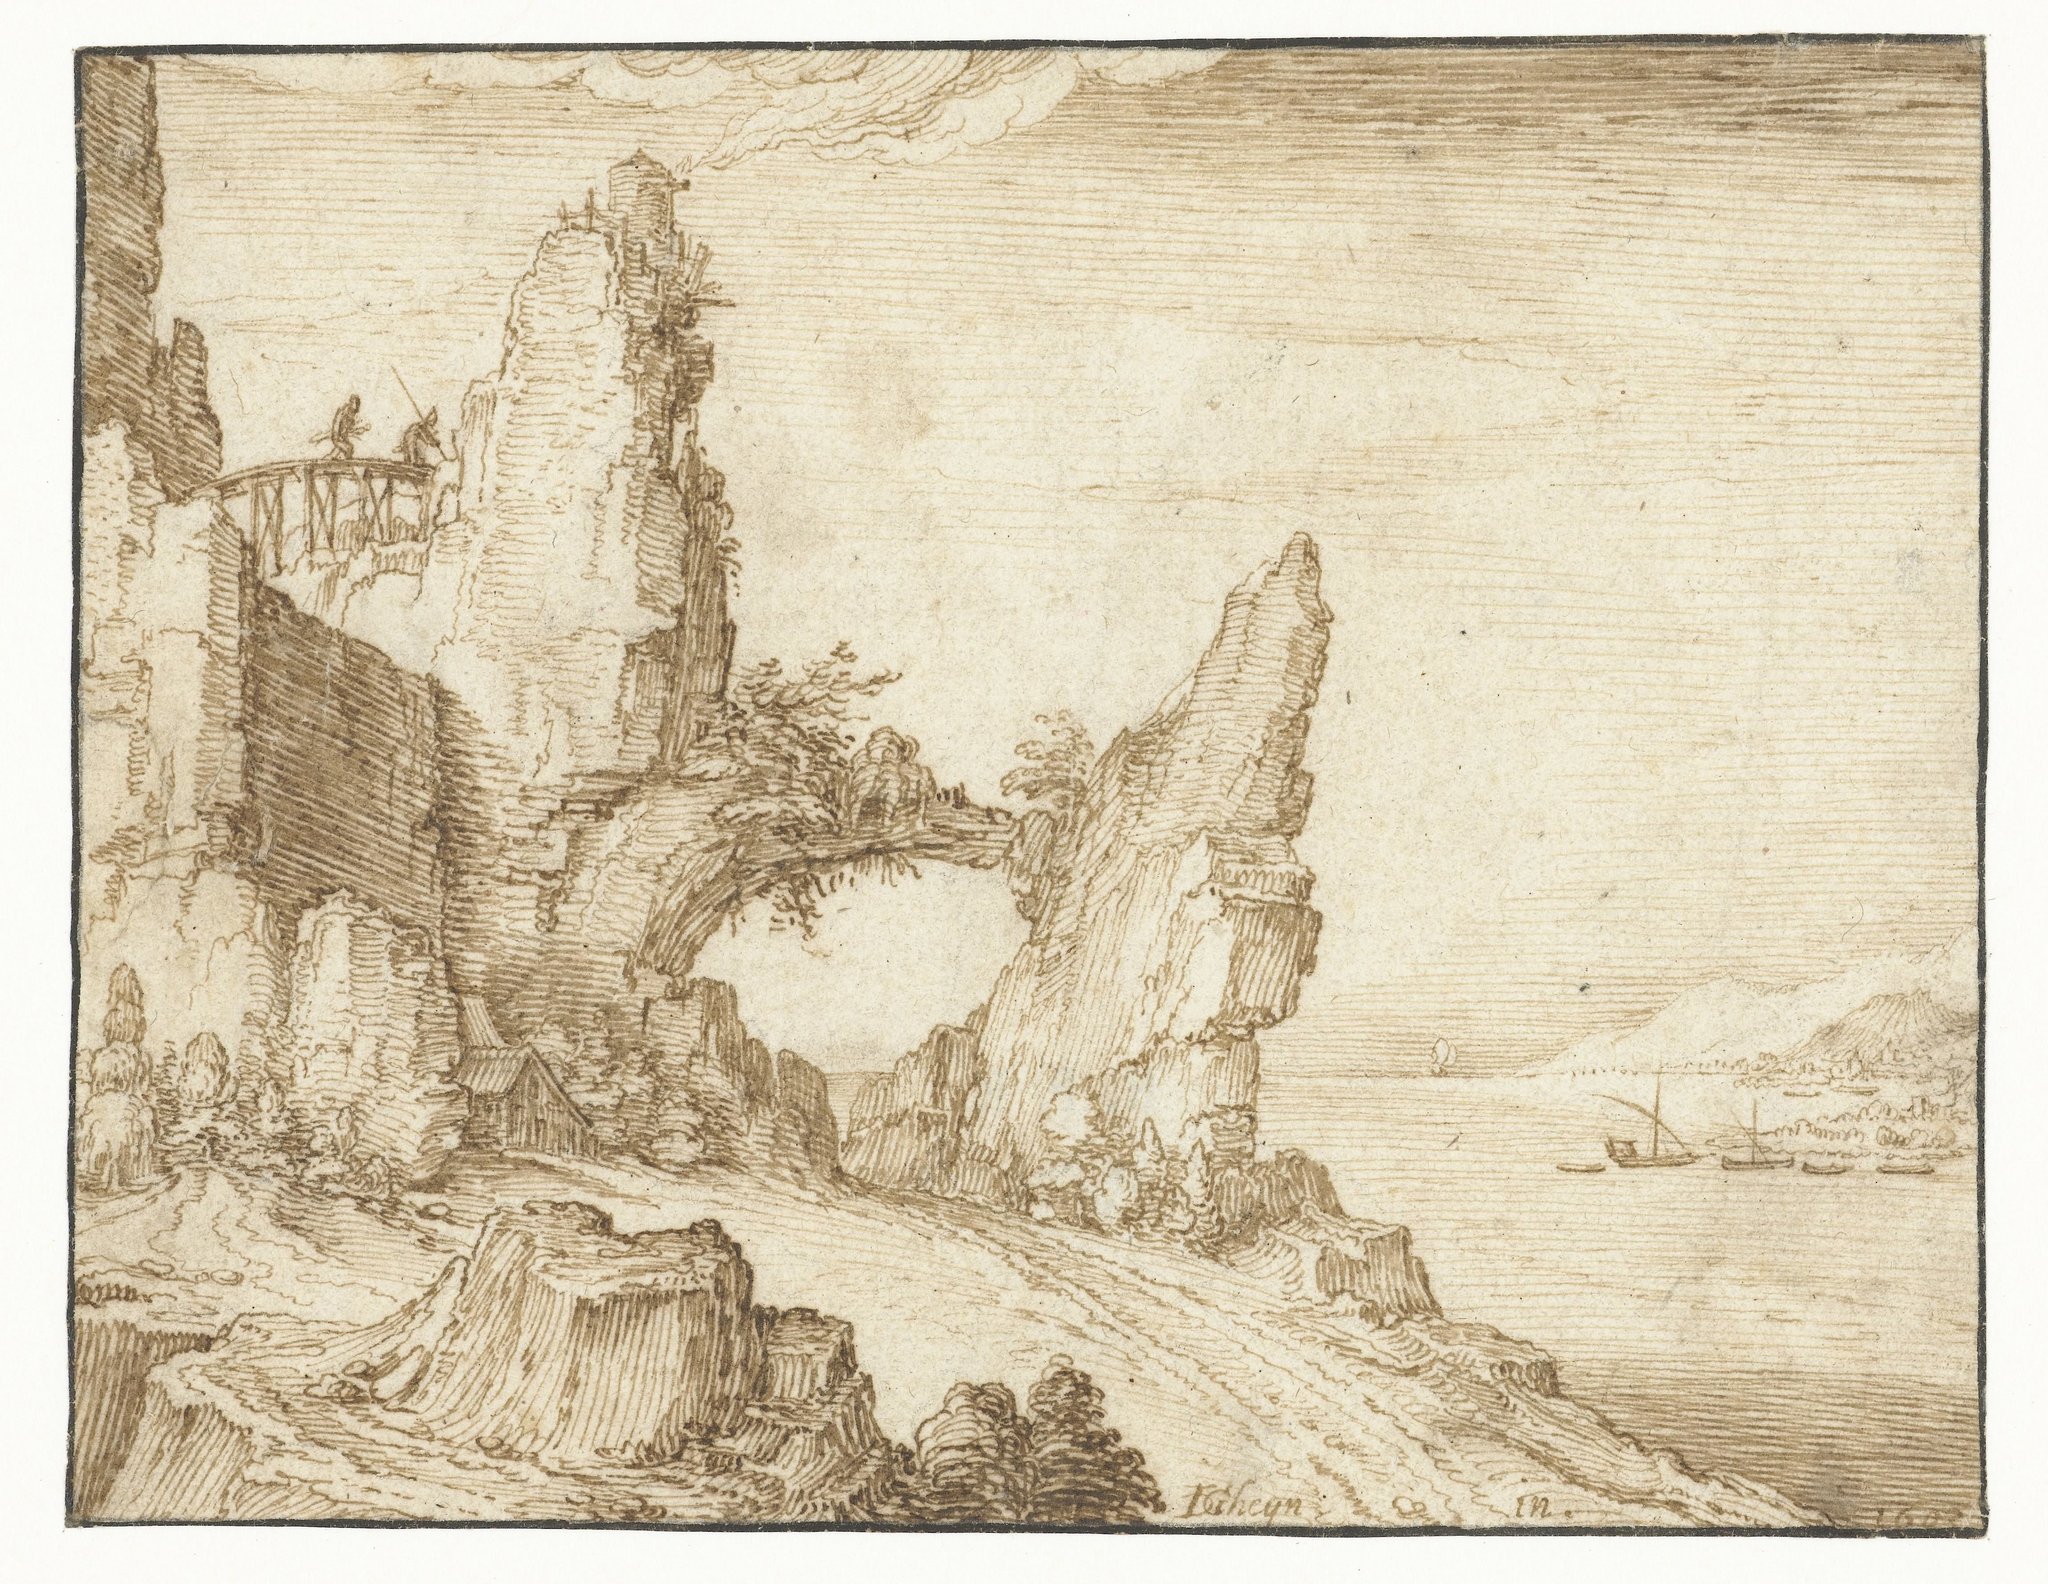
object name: drawing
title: Landscape with steep rock formations along a river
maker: jacques de gheyn (ii)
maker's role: painter, print maker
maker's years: 1565-1629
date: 1603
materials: ink, paper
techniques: pen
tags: river, rocks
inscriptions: date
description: De Gheyn adjusted his drawing technique to the size of the paper. He gave form to this landscape with extremely fine lines. He drew a few boats on the water, a mountain hut hidden in the craggy rocks, and a tower with a smoking chimney atop the cliffs. The two figures crossing the wooden bridge are entirely disproportional to the rest of the composition.